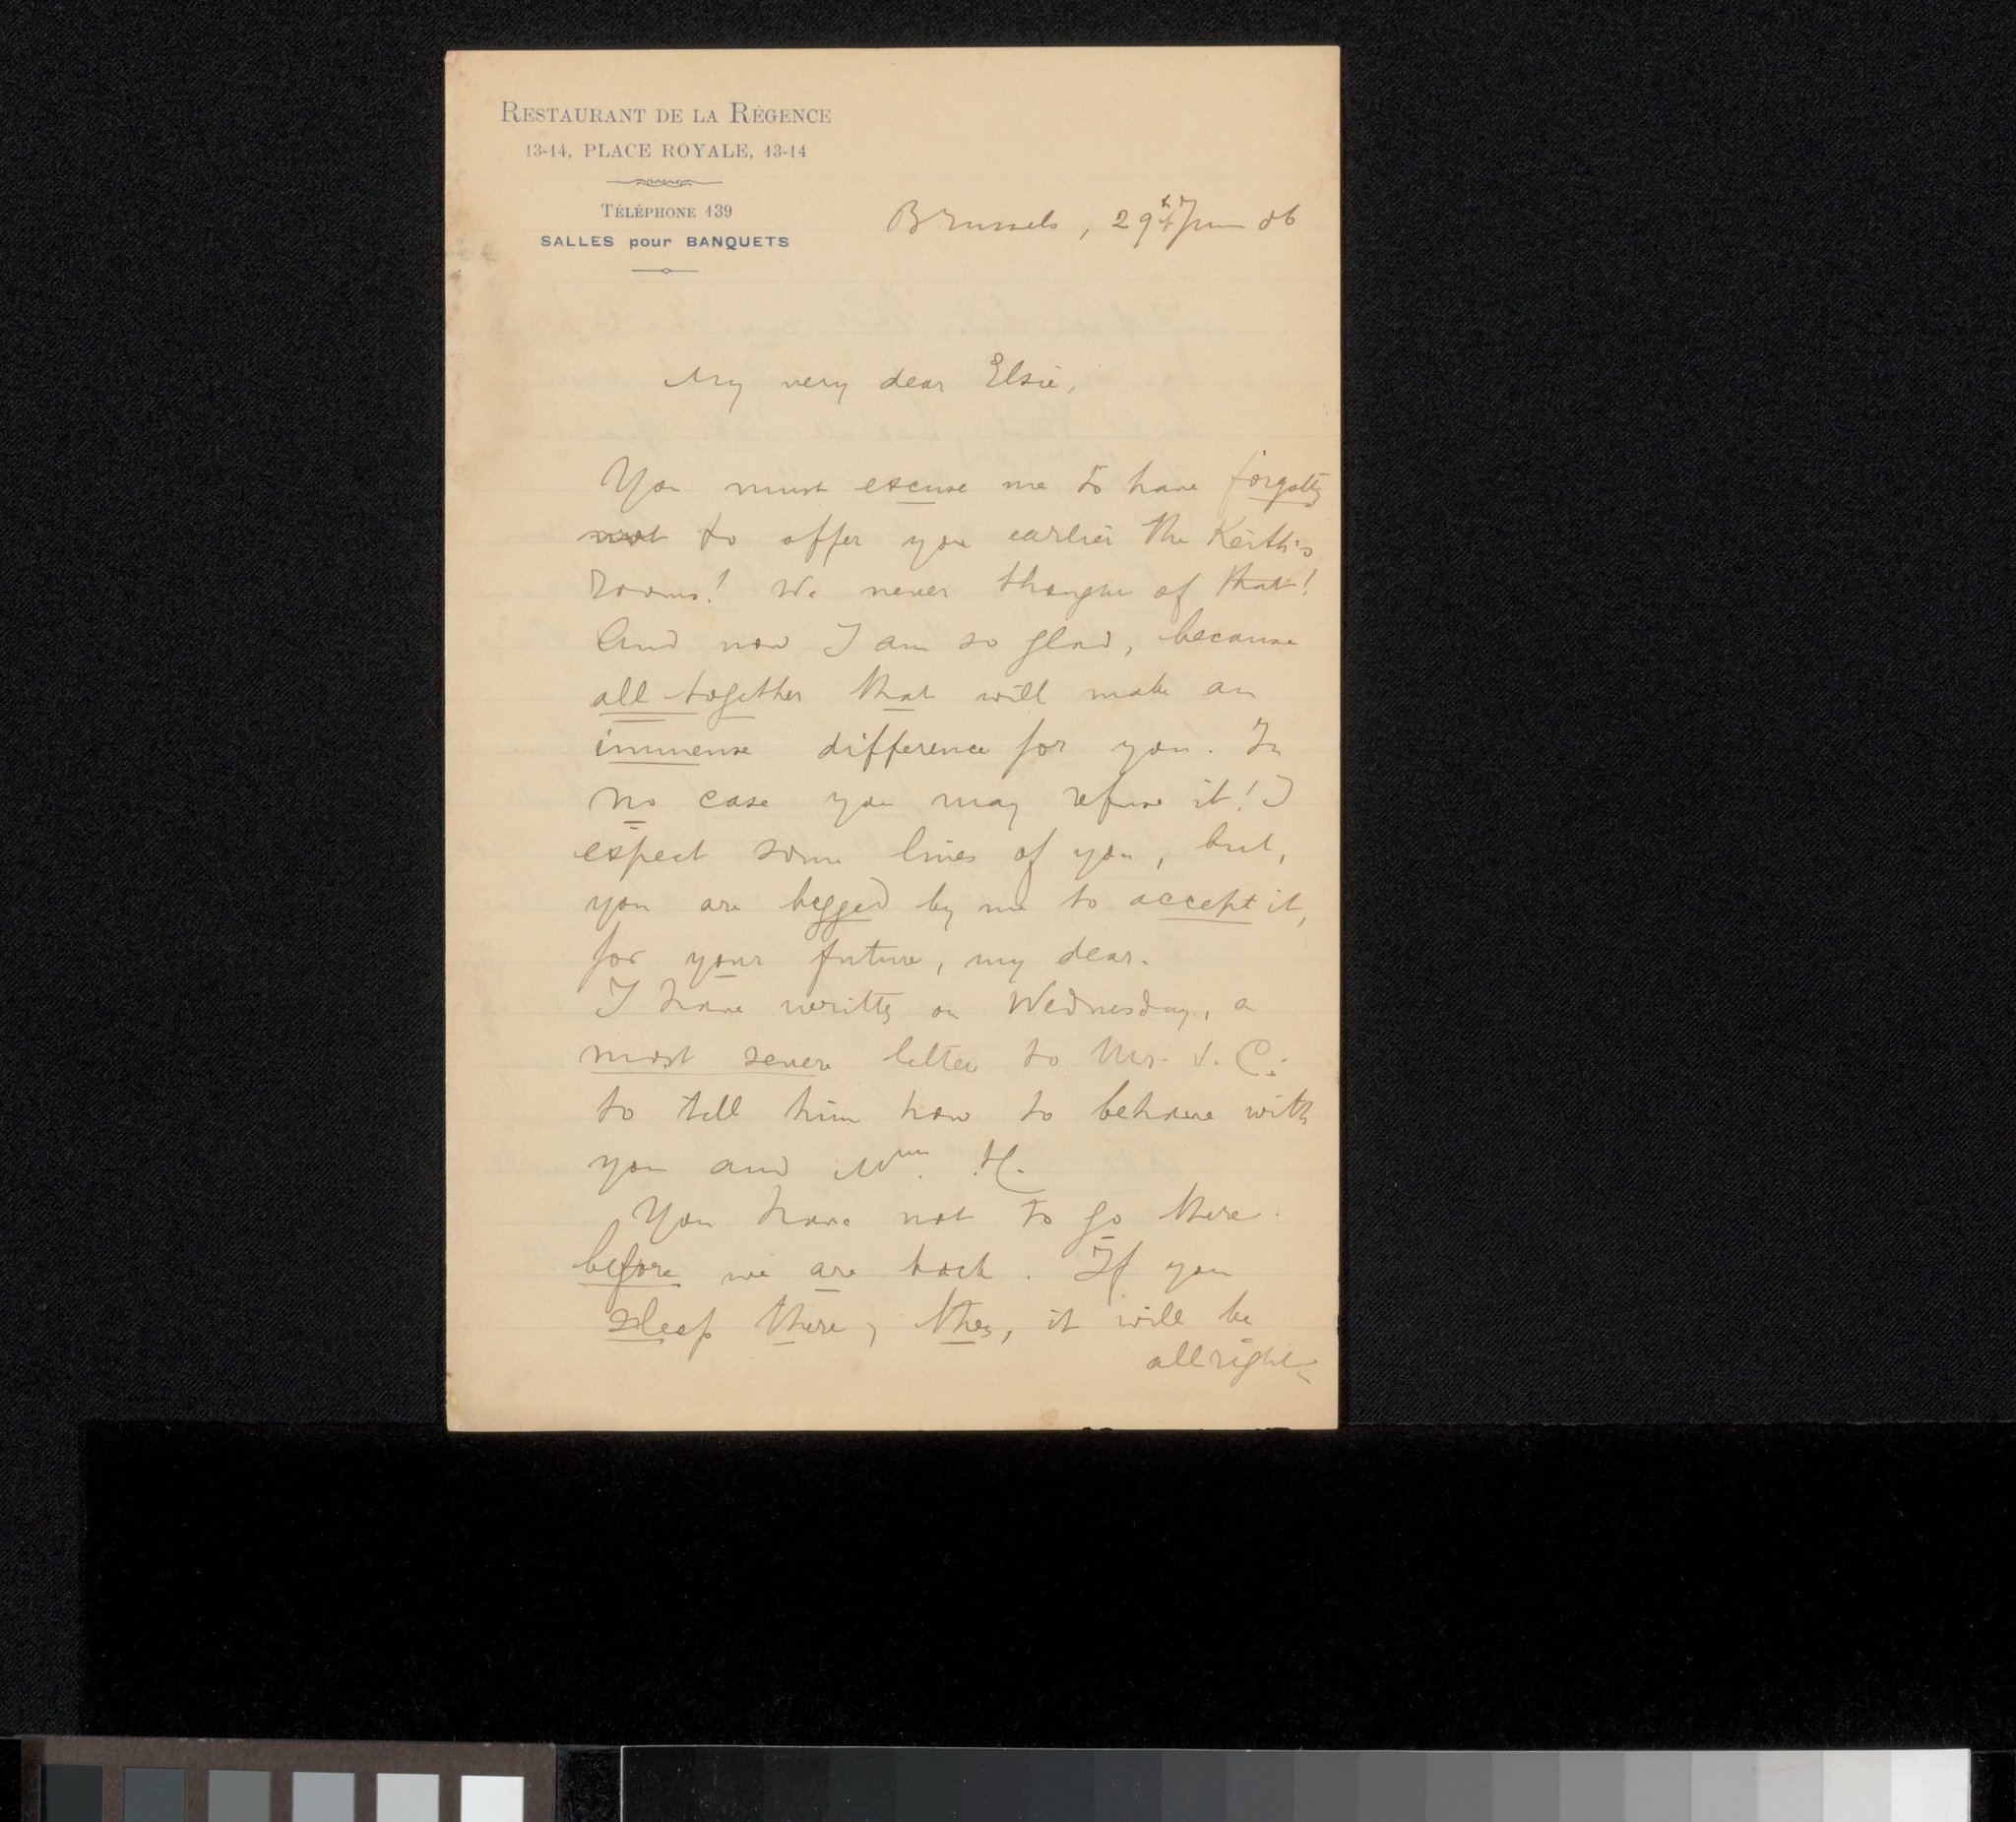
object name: letter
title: Brief aan Elsie Maud Cownie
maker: philip zilcken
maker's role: draughtsman, painter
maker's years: 1857-1930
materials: ink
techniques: pen, printing, writing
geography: brussels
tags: manchester, elsie maud cownie, workshop, studio of the artist (in general), money